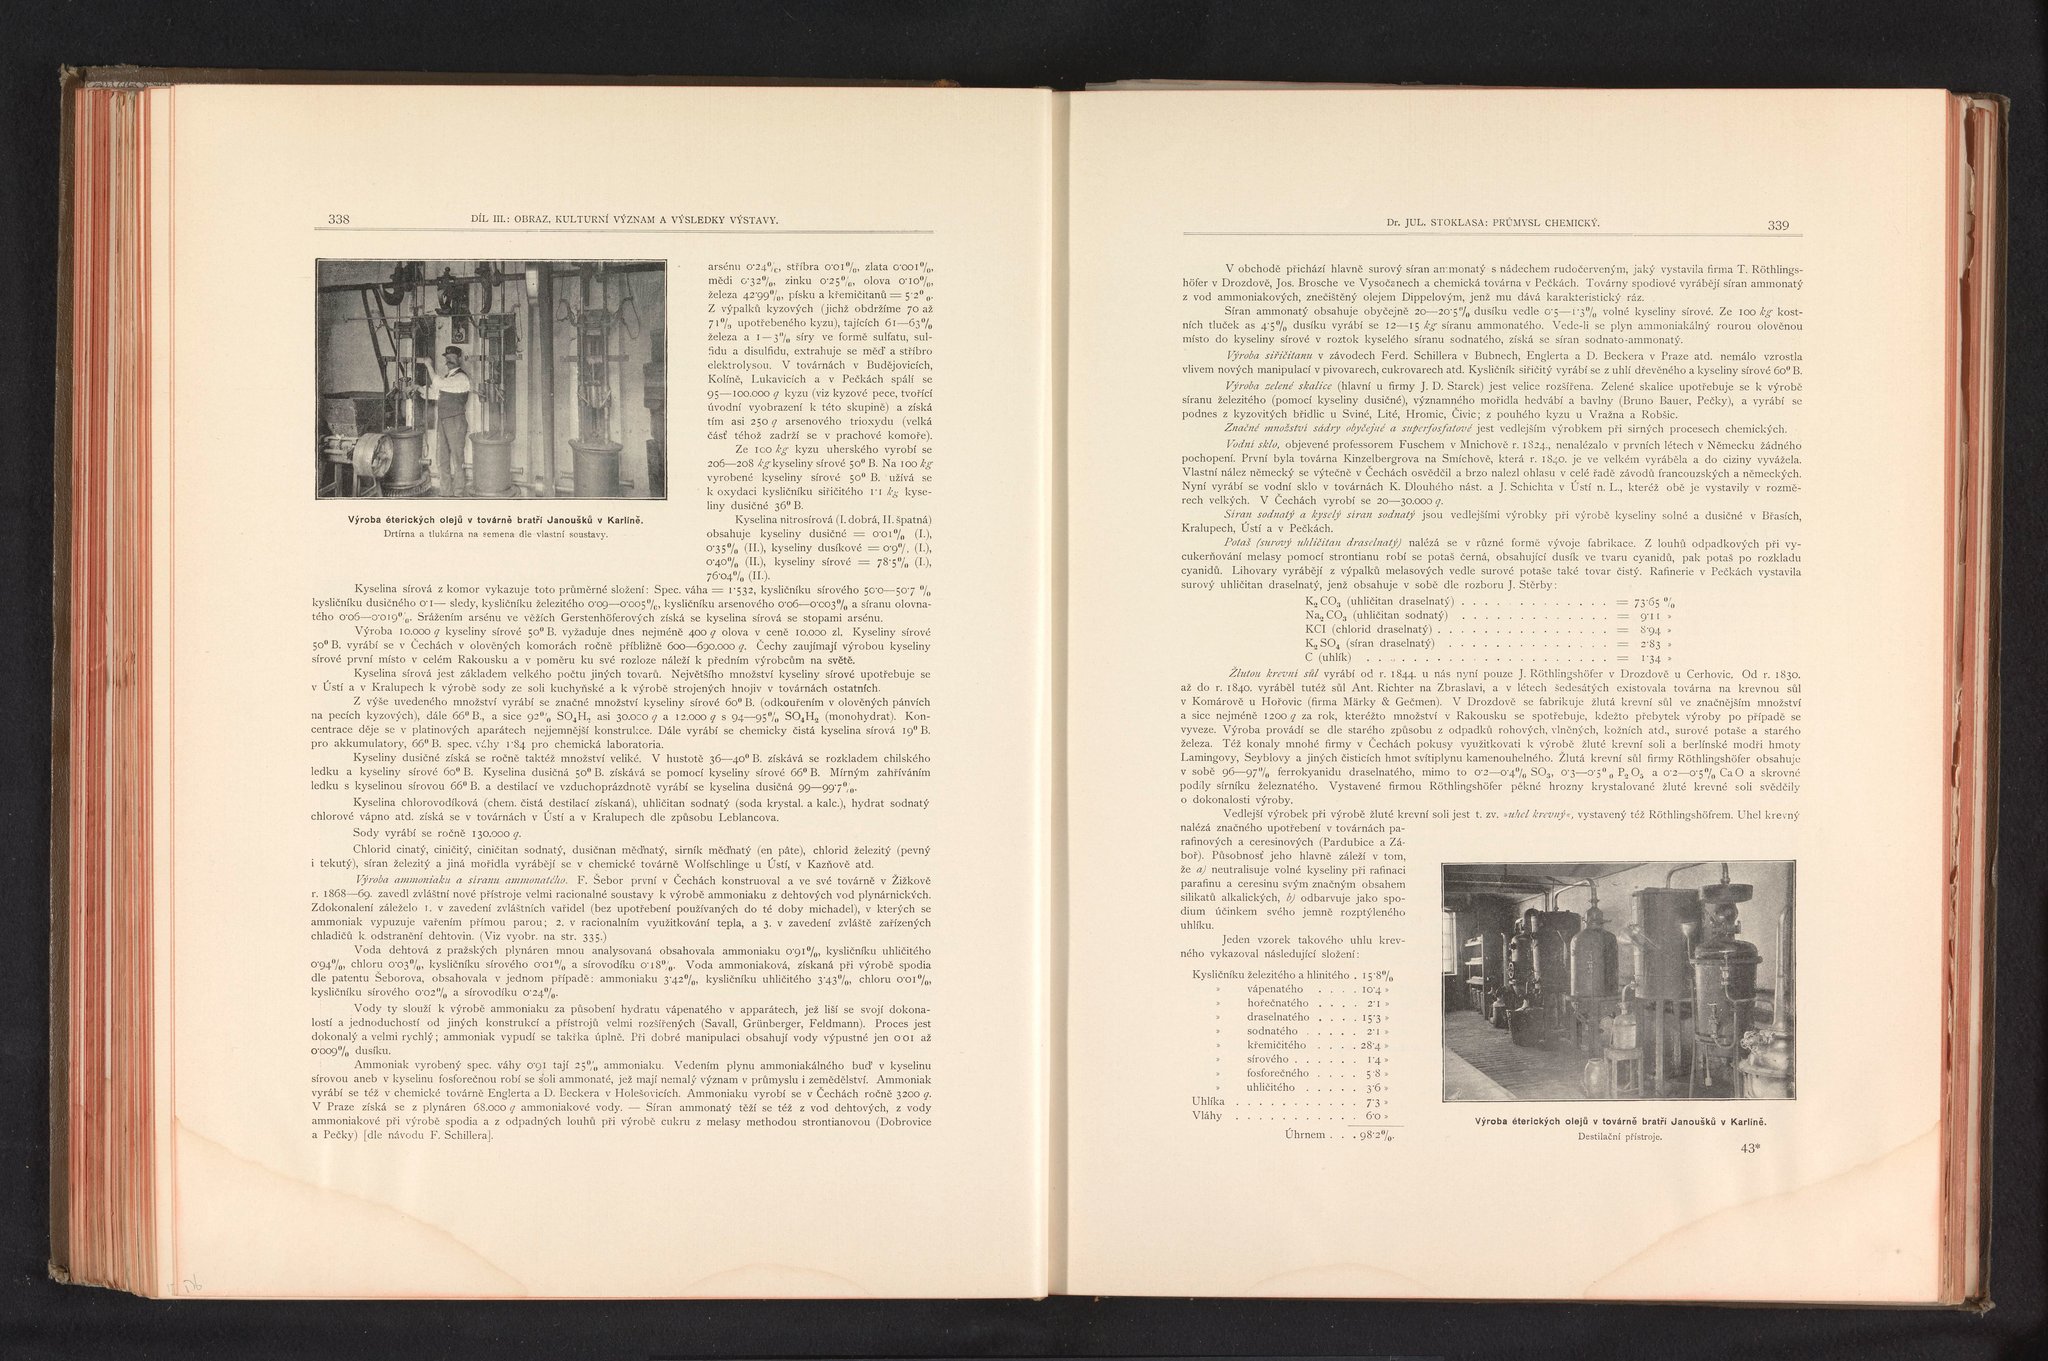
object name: page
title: Výroba éterických oleju v továrna bratri Janousku v Karline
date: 1890-1895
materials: paper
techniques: autotype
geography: prague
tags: chandelier, candelabrum